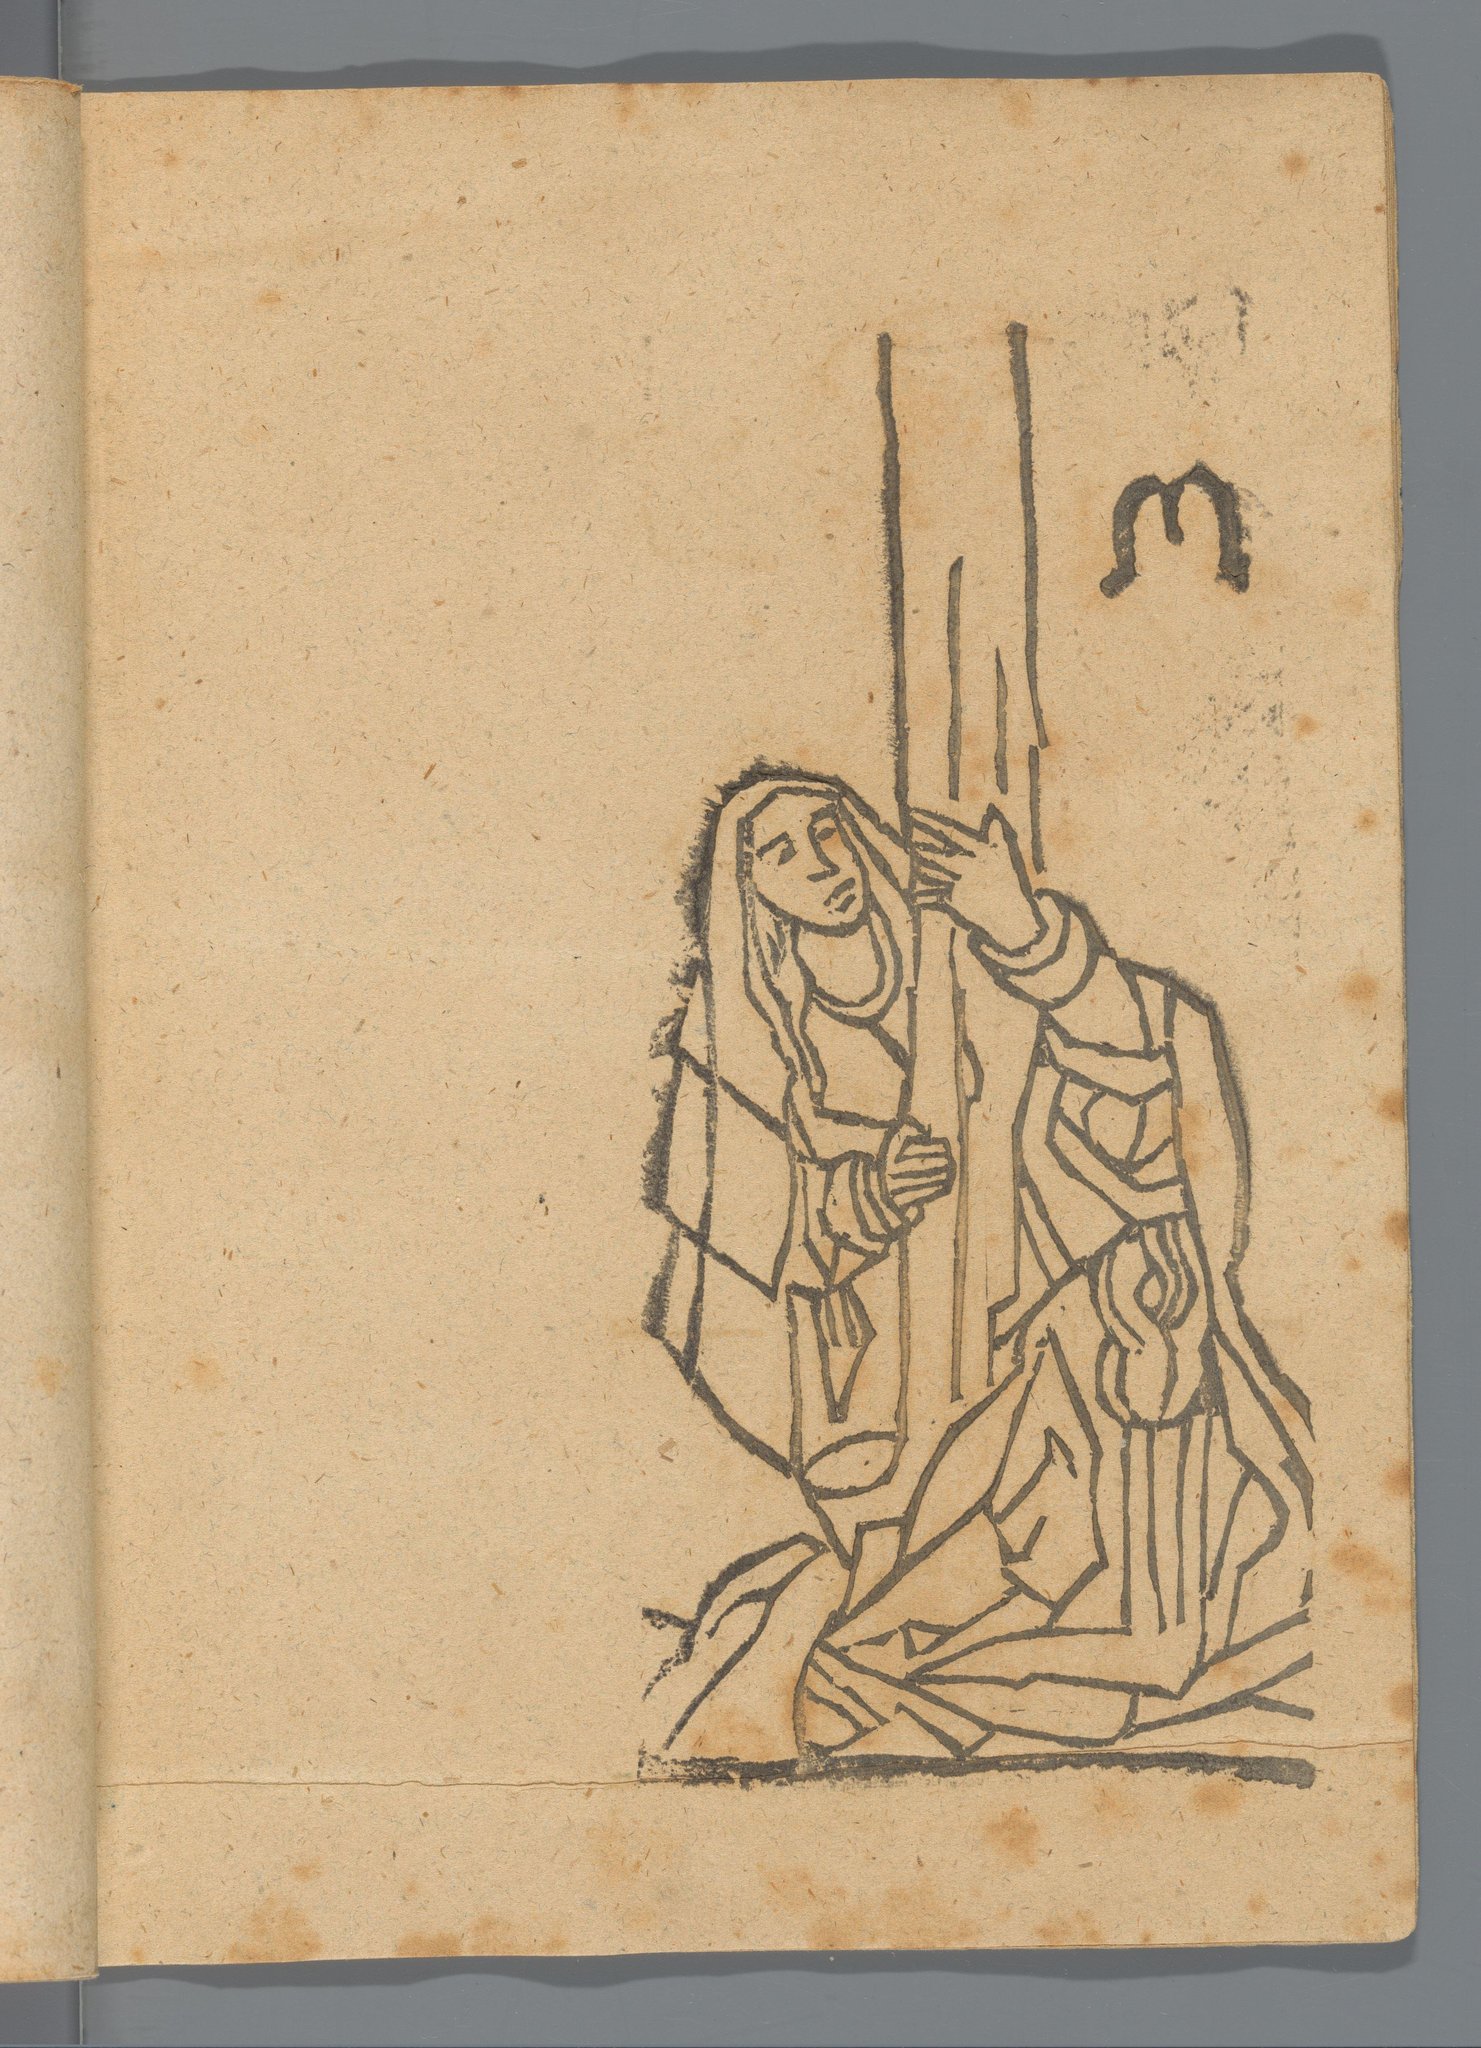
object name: album leaf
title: Onbekende heilige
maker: Anonymous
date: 1800-1899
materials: paper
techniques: woodcut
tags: saints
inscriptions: collector's mark: Lugt 2166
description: Deze prent maakt deel uit van een album.